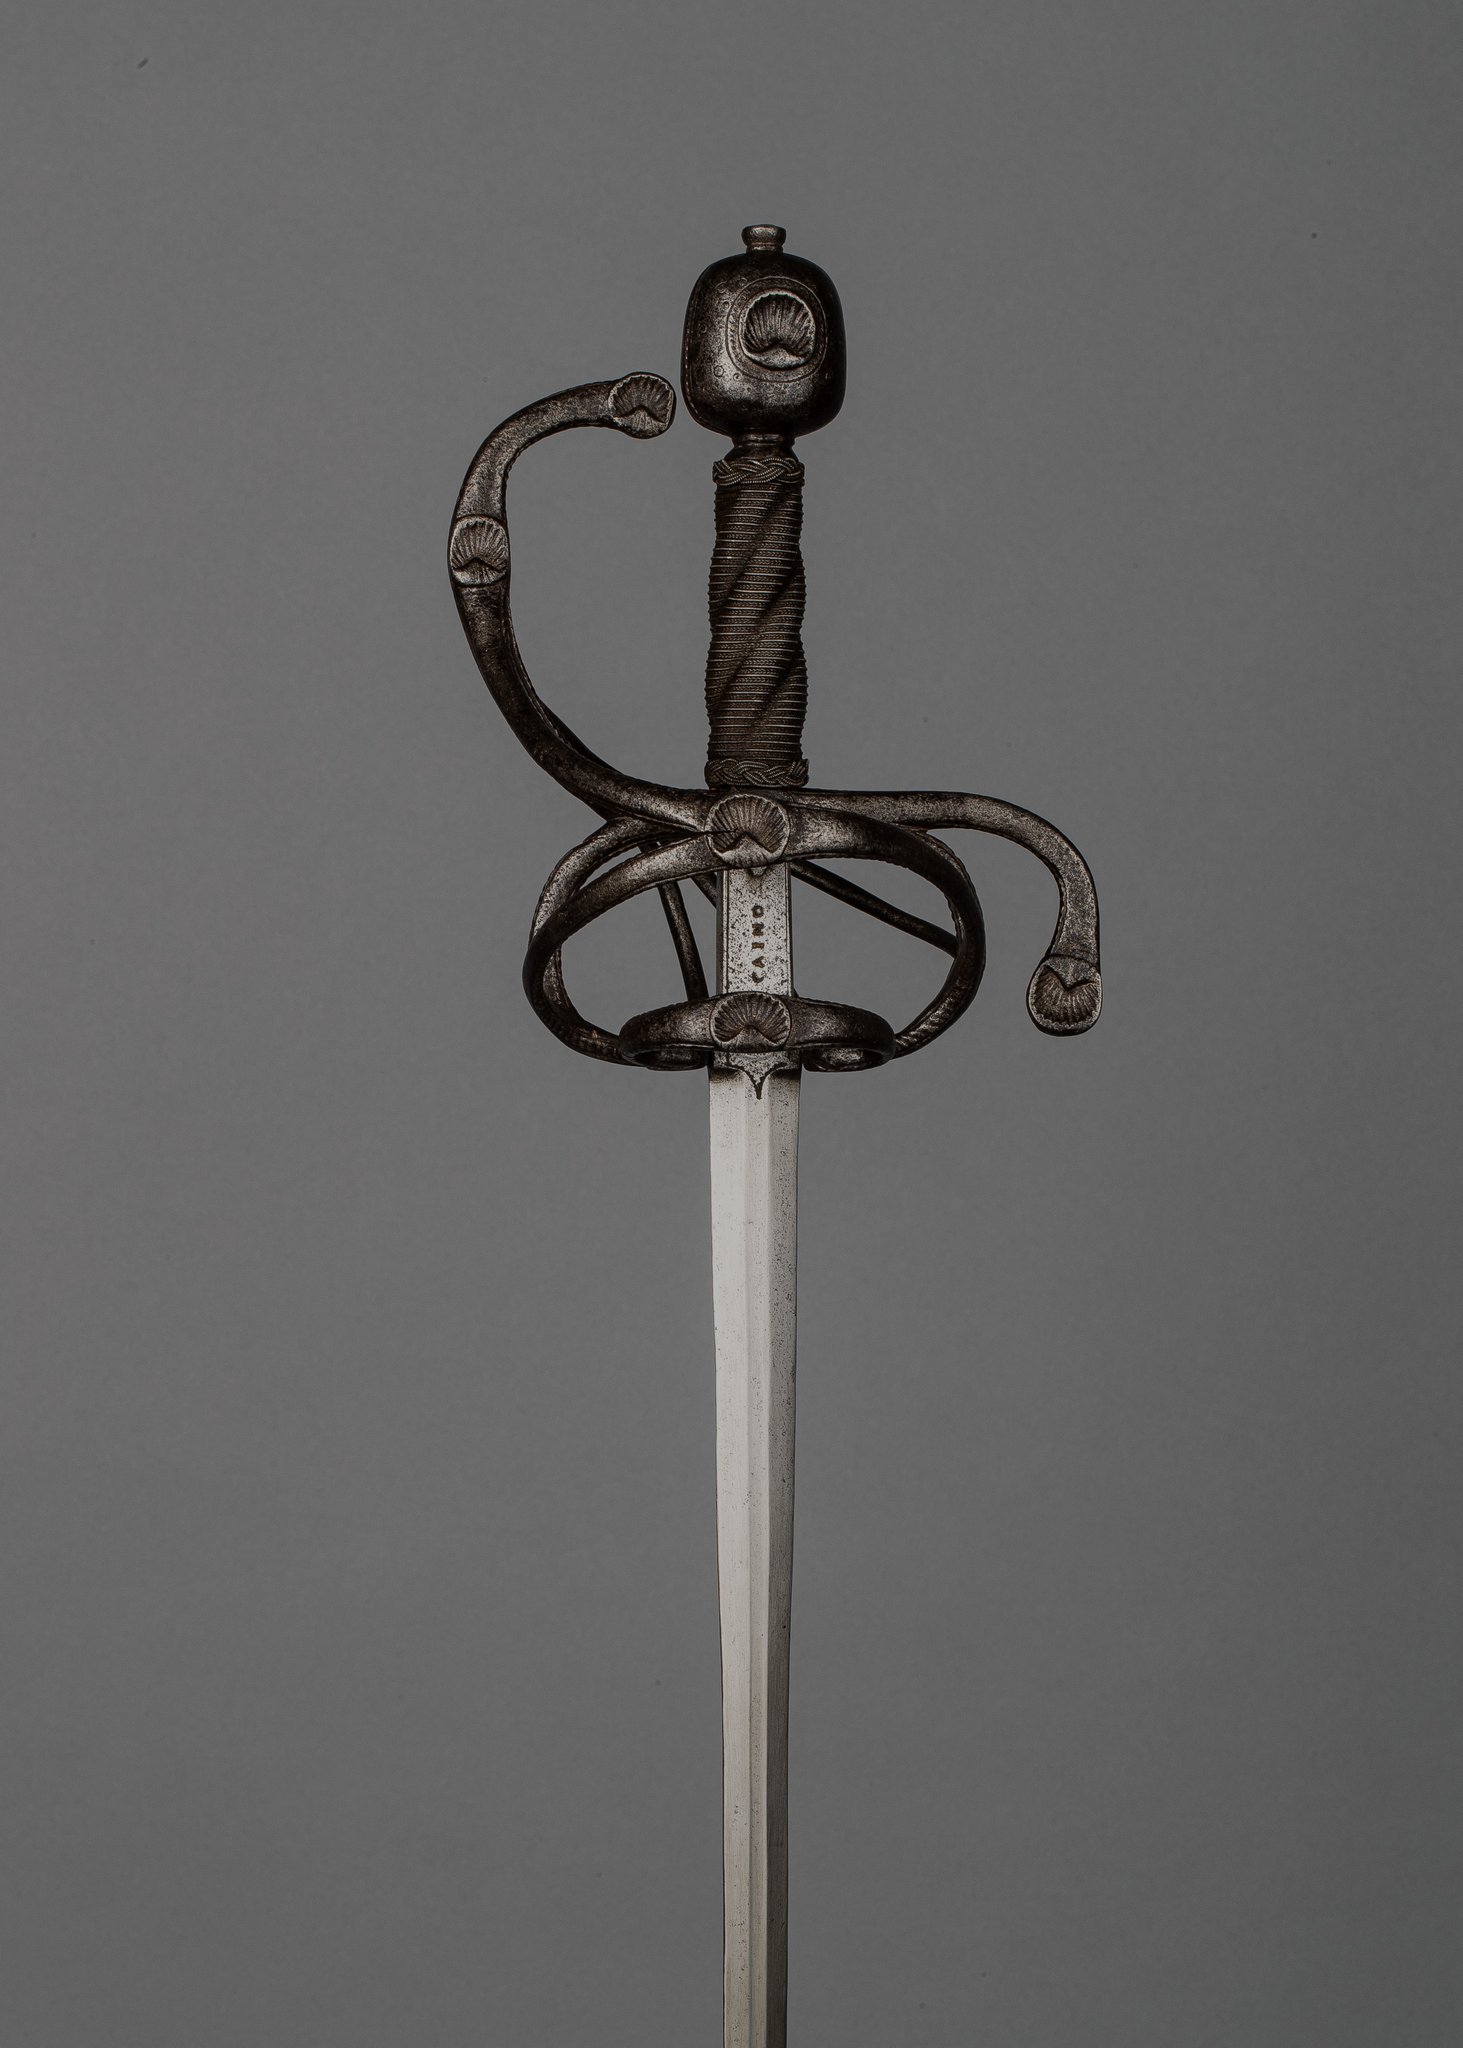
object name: rapier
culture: spanish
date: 1567-1600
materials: steel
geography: spain